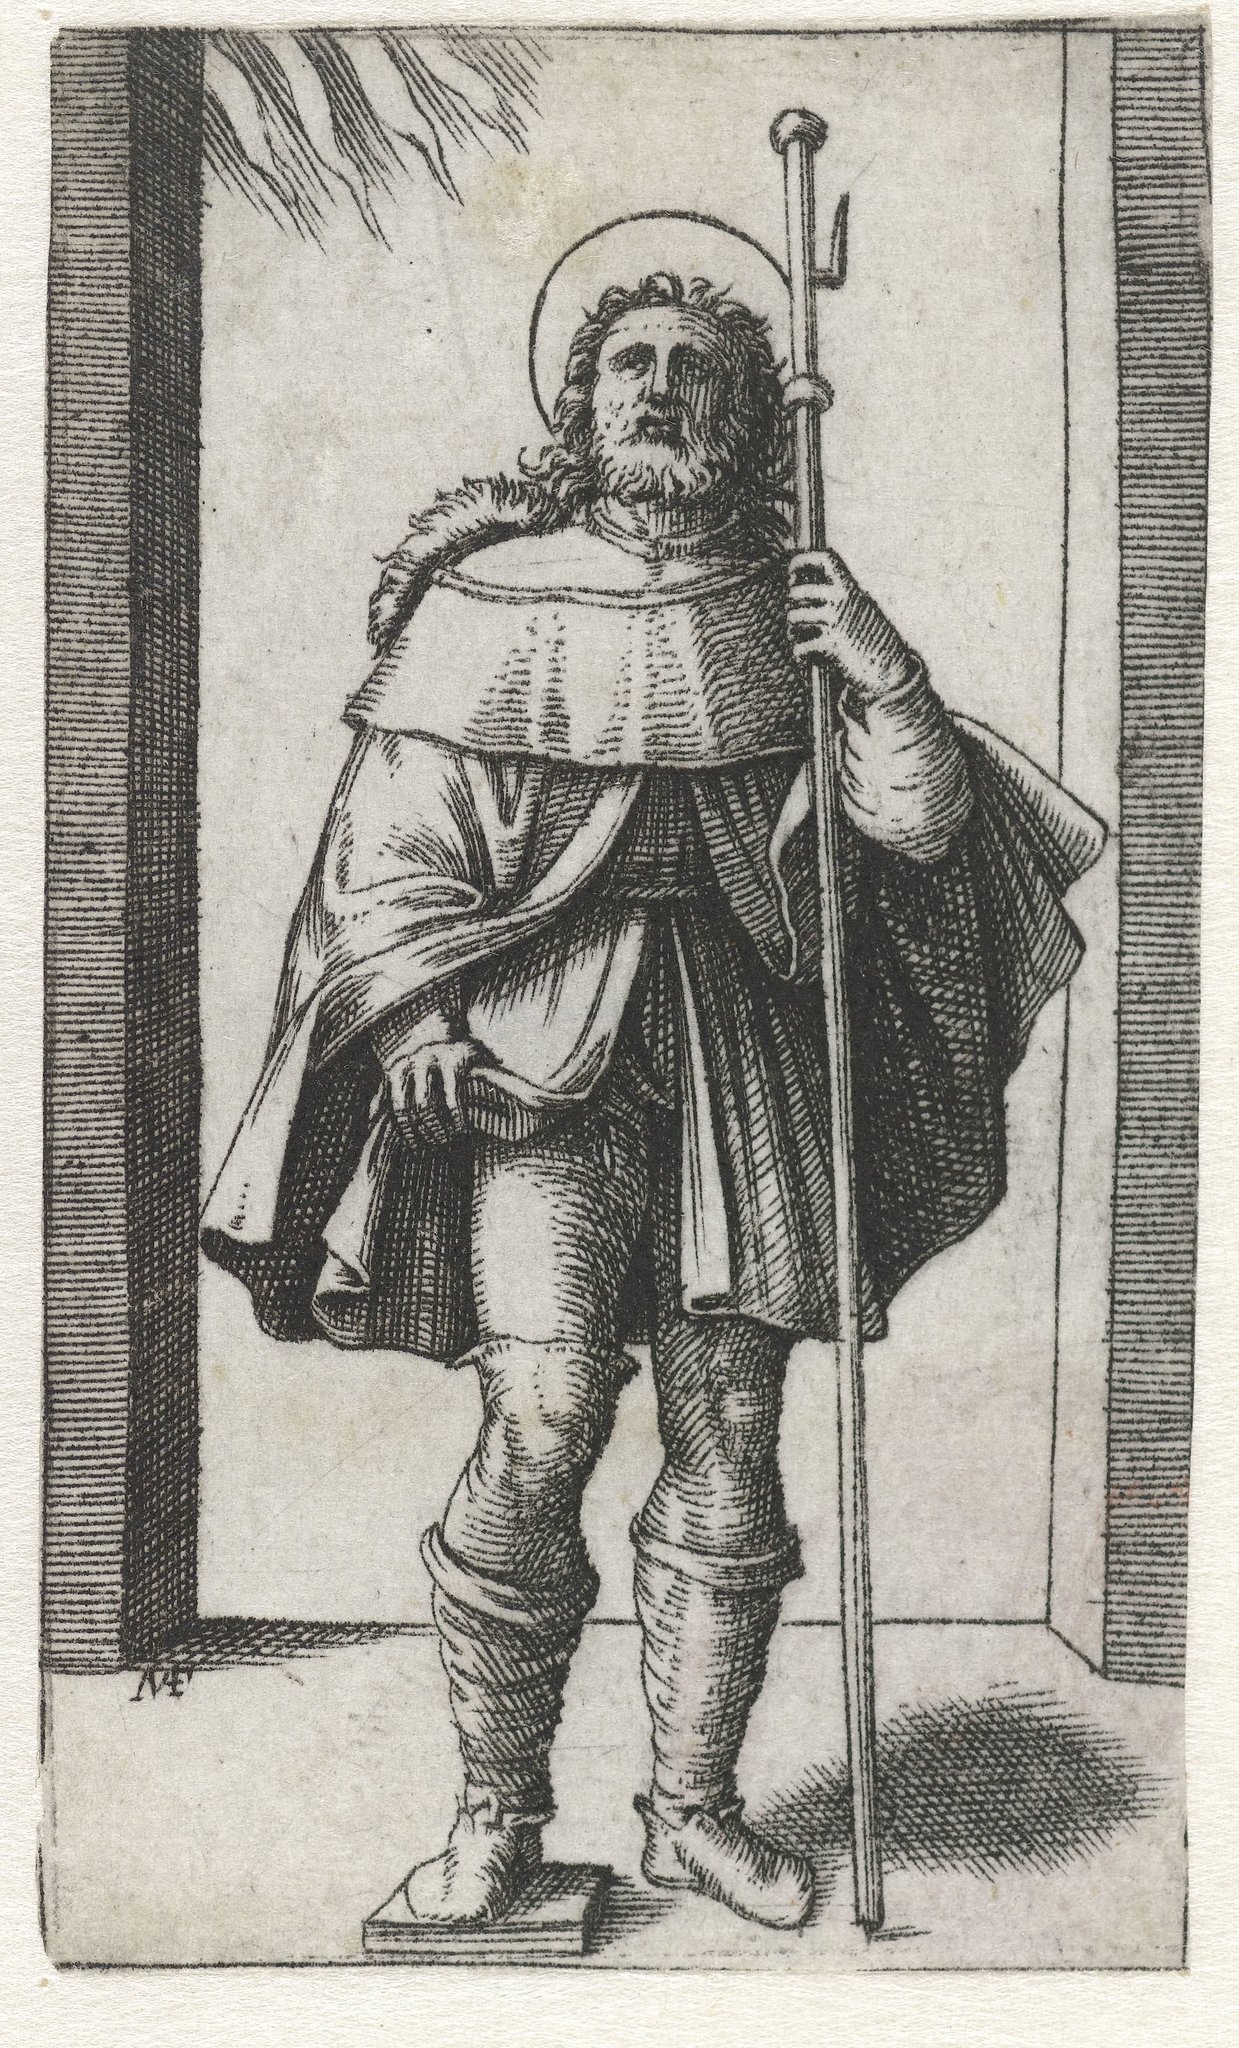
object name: print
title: Heilige Rochus als pelgrim met pelgrimsstaf toont pestbult op been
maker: marcantonio raimondi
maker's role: print maker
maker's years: 1470-1534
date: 1500-1527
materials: paper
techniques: engraving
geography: italy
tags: the confessor and pilgrim roch(us) (rocco, rock) of montpellier; possible attributes: angel (with ointment box or spoon), dog (sometimes with loaf), (pointing at) plague-spot on thigh, pilgrim's shell, staff, hat and wallet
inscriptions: collector's mark: Lugt 12